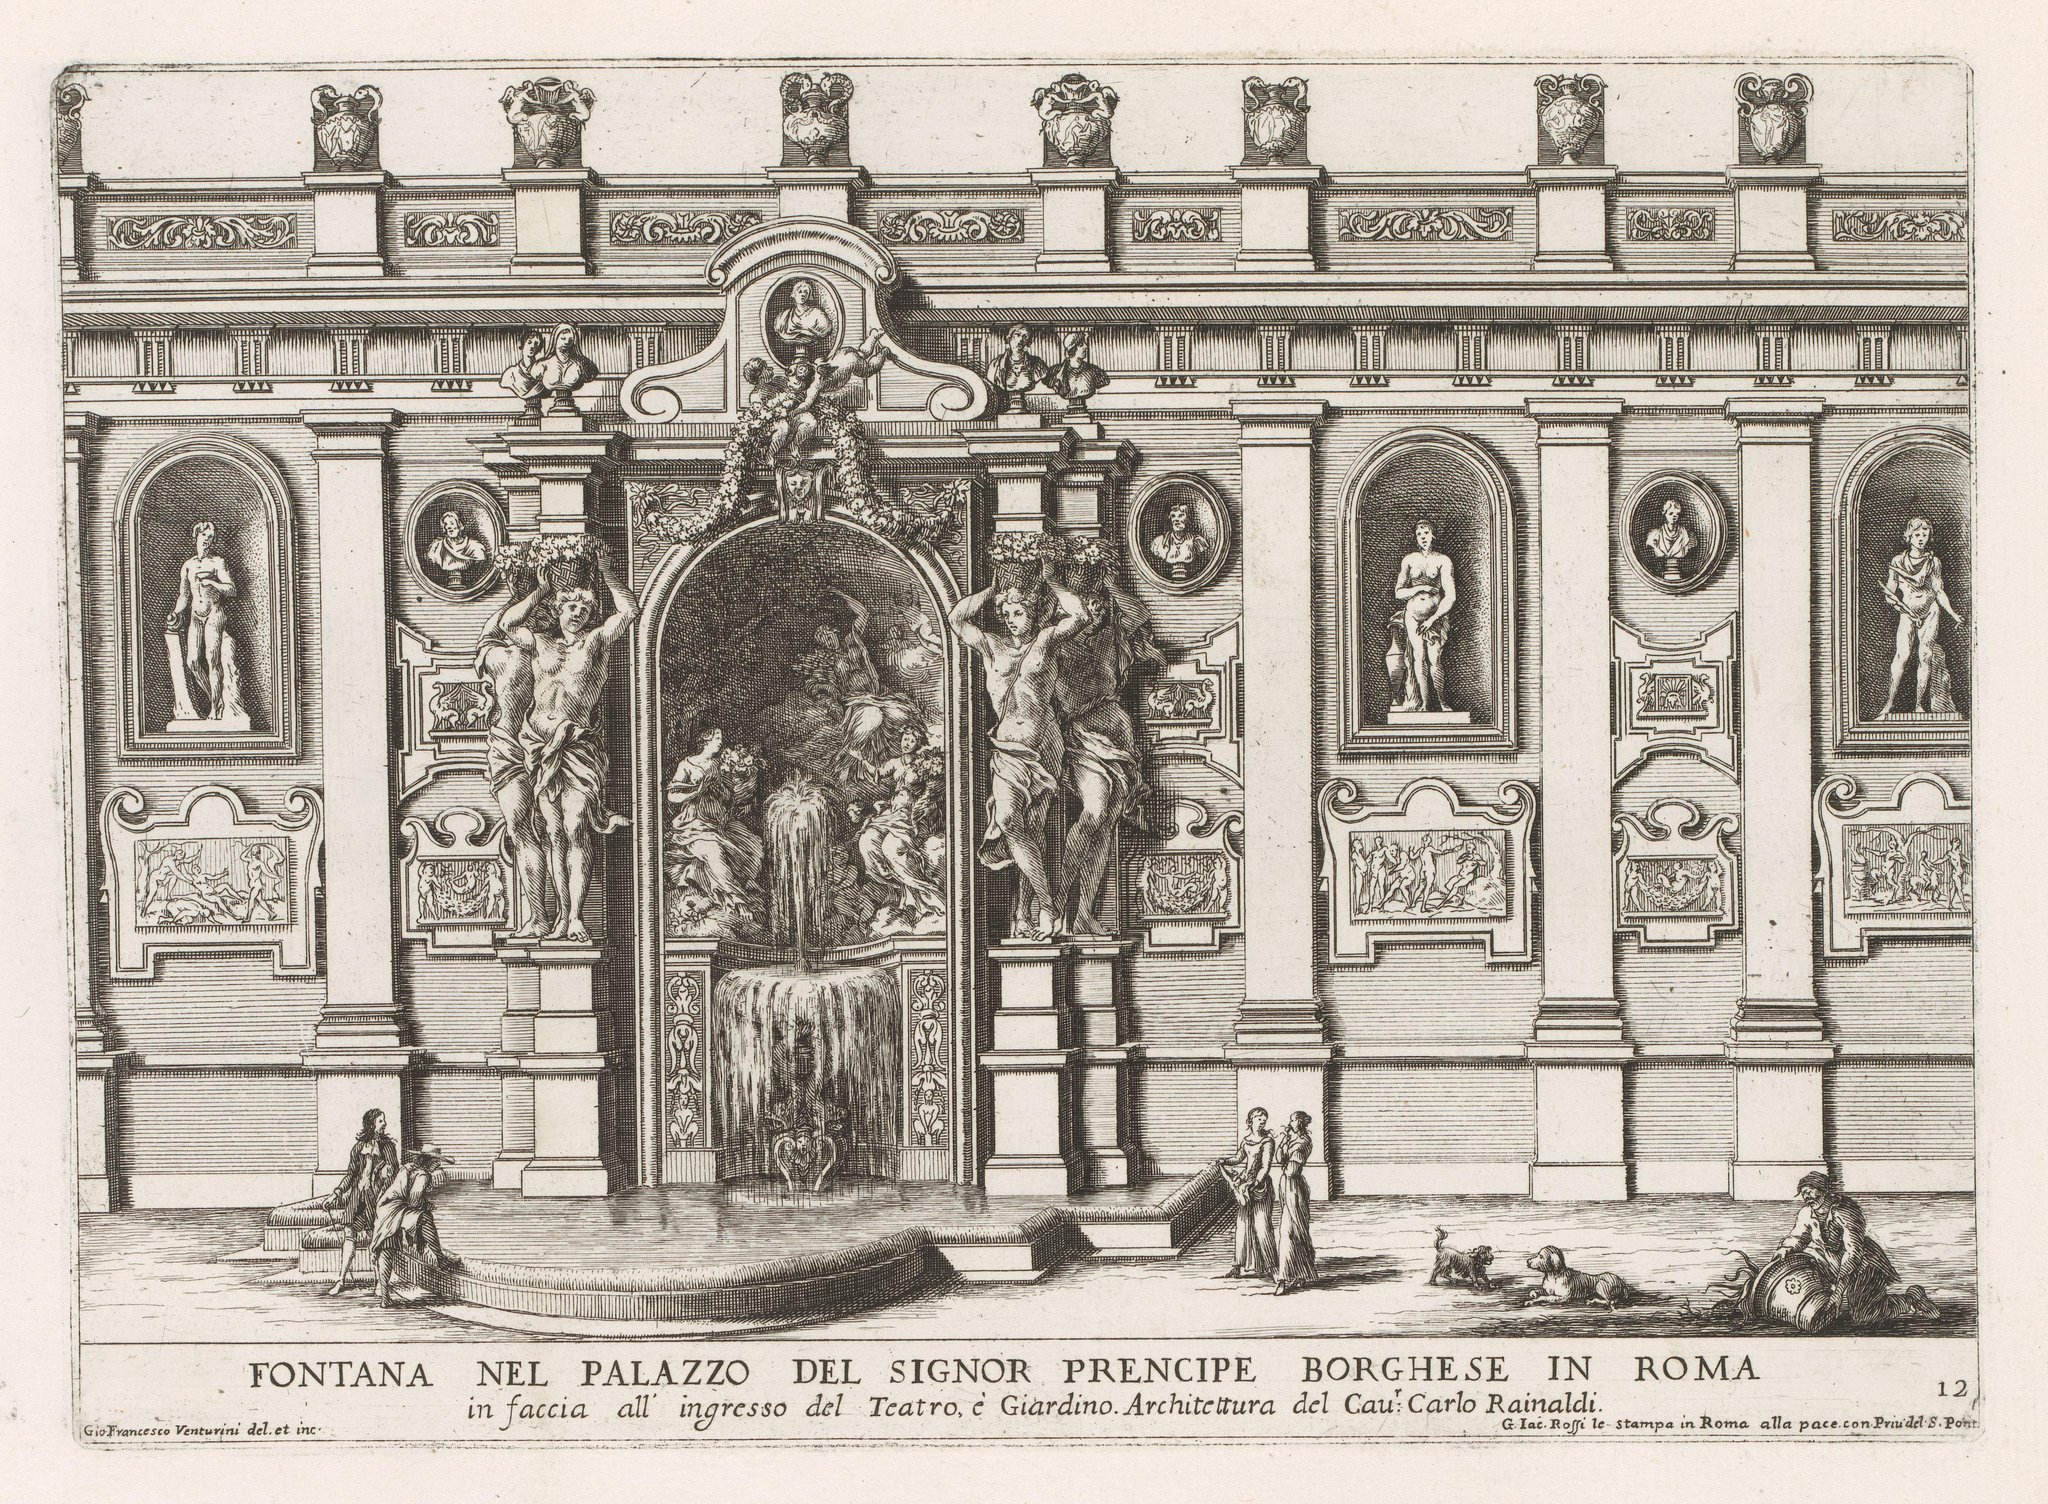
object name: album leaf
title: Le fontane ne palazzi e ne giardini di Roma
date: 1653-1691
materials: paper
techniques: etching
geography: vatican city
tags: piece of sculpture, reproduction of a piece of sculpture, ornamental fountain, rome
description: Genummerd rechtsonder: 12. De prent maakt deel uit van een album.